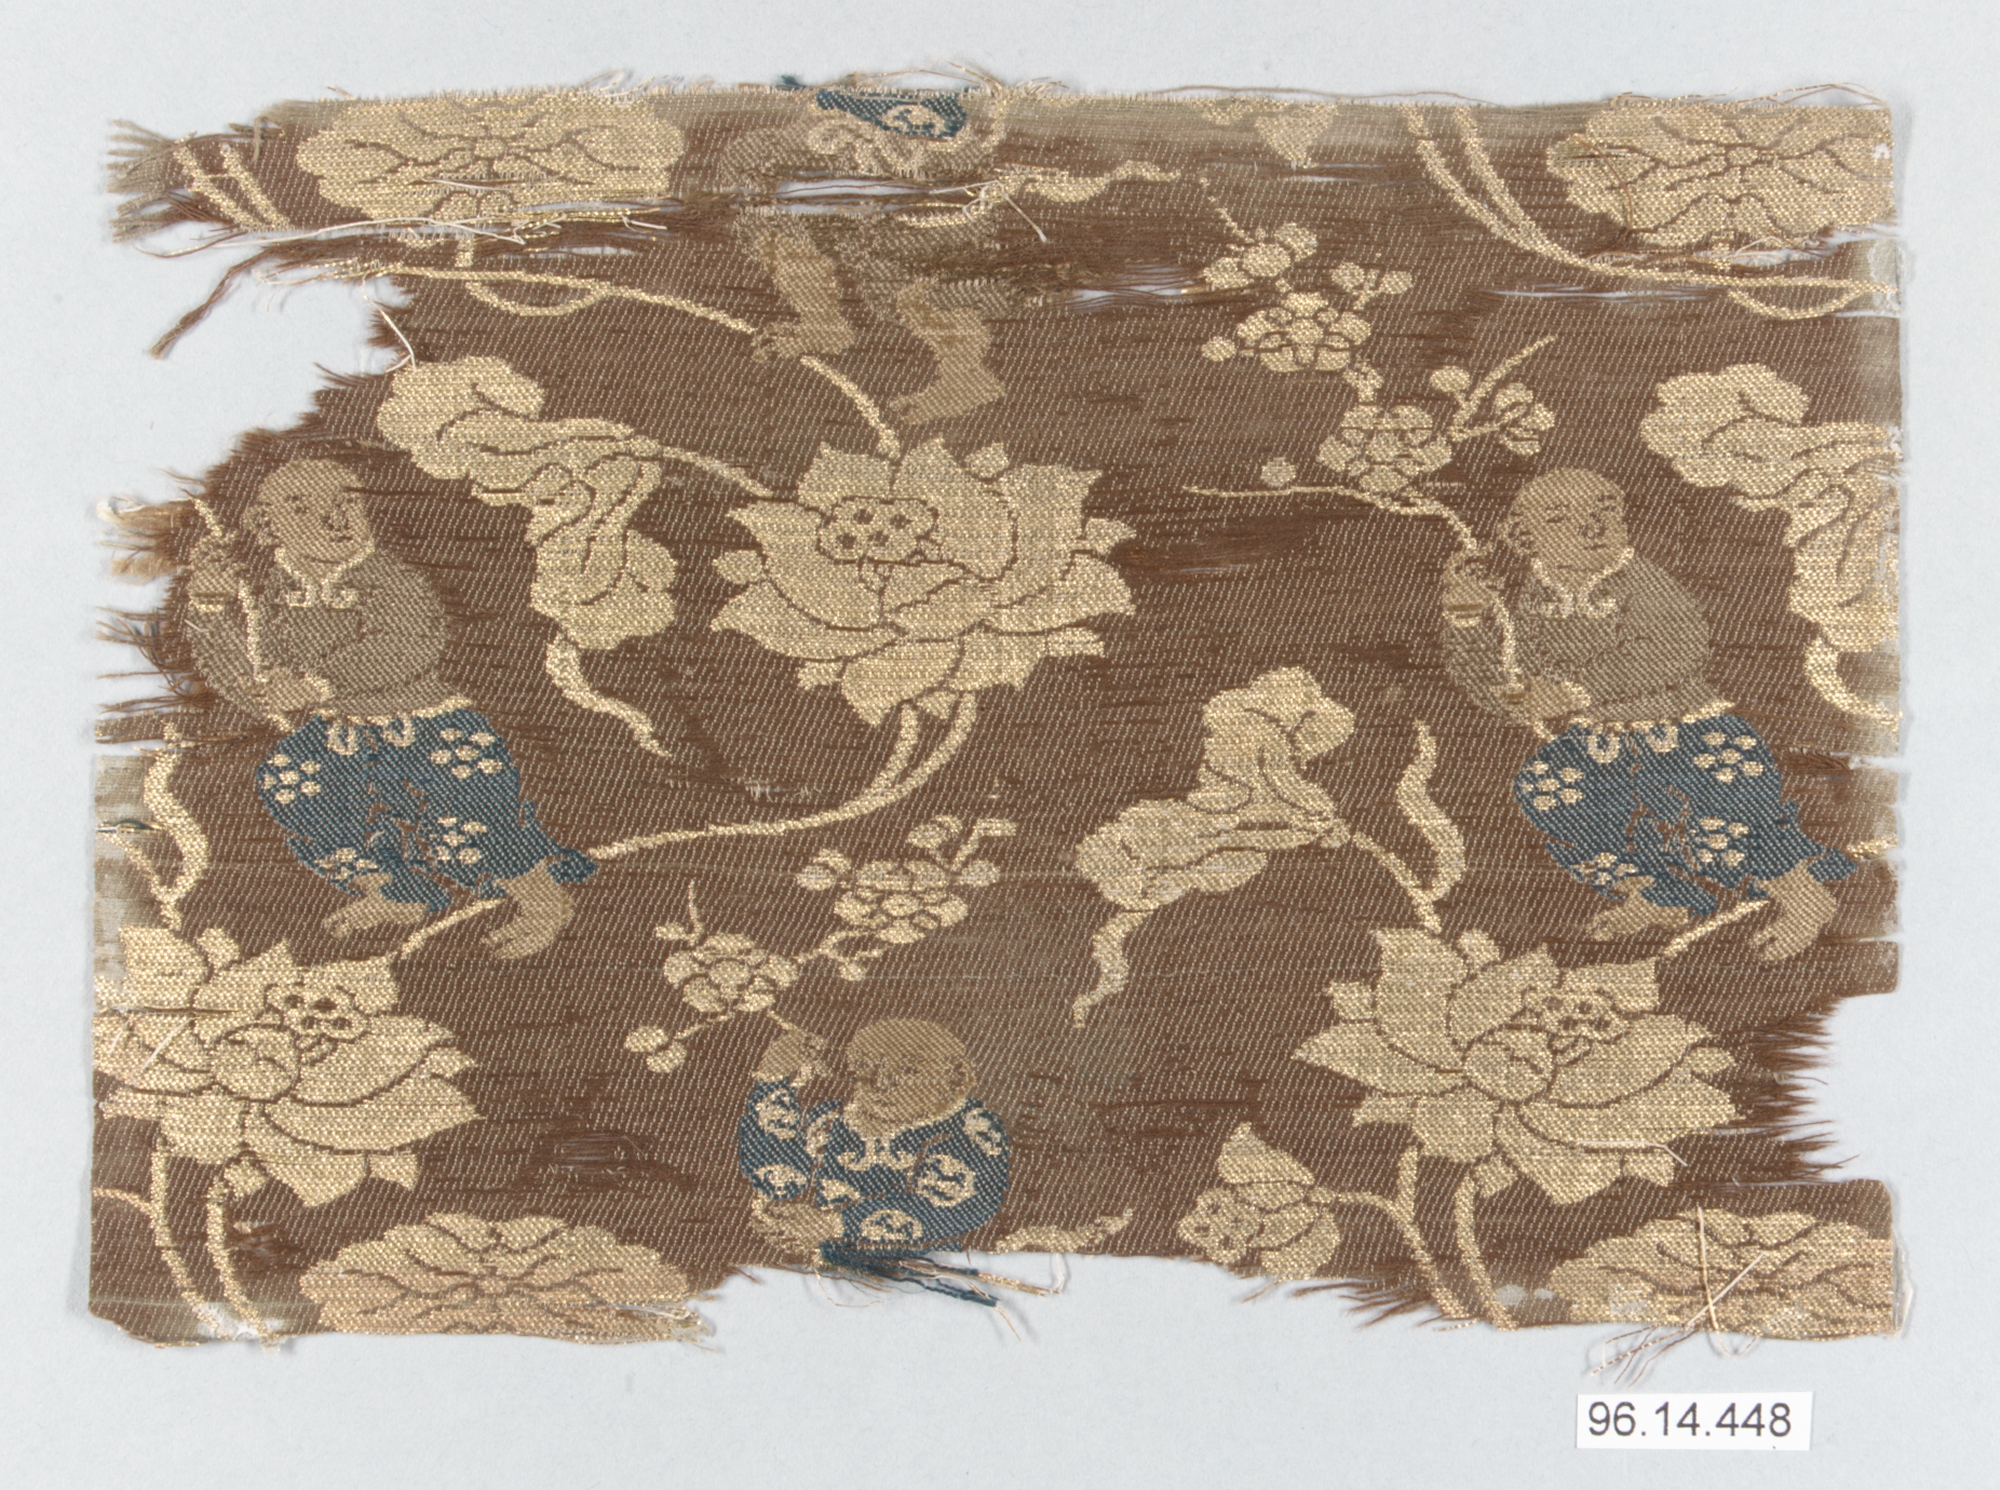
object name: piece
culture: japanese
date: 1701-1900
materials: silk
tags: flowers